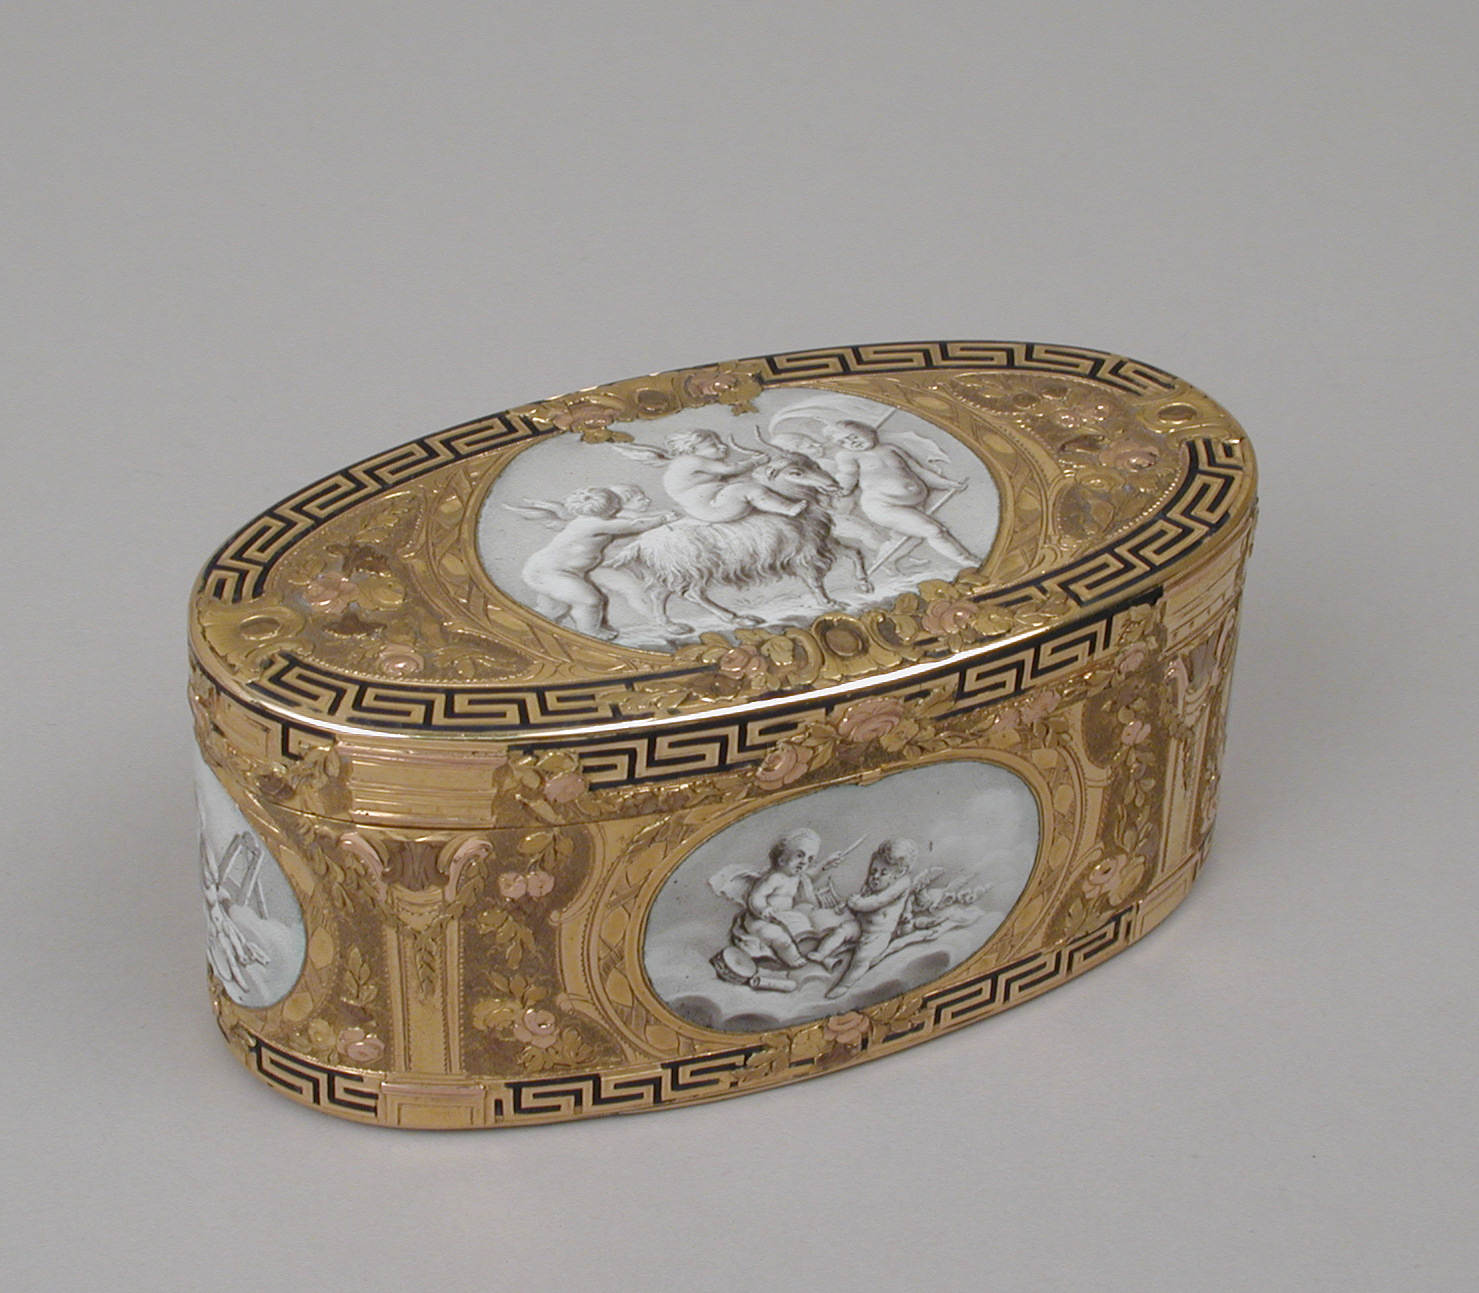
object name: snuffbox, painting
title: Snuffbox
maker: a. p. c., switzerland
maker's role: maker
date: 1770-1775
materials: enamel, gold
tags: putti,goats